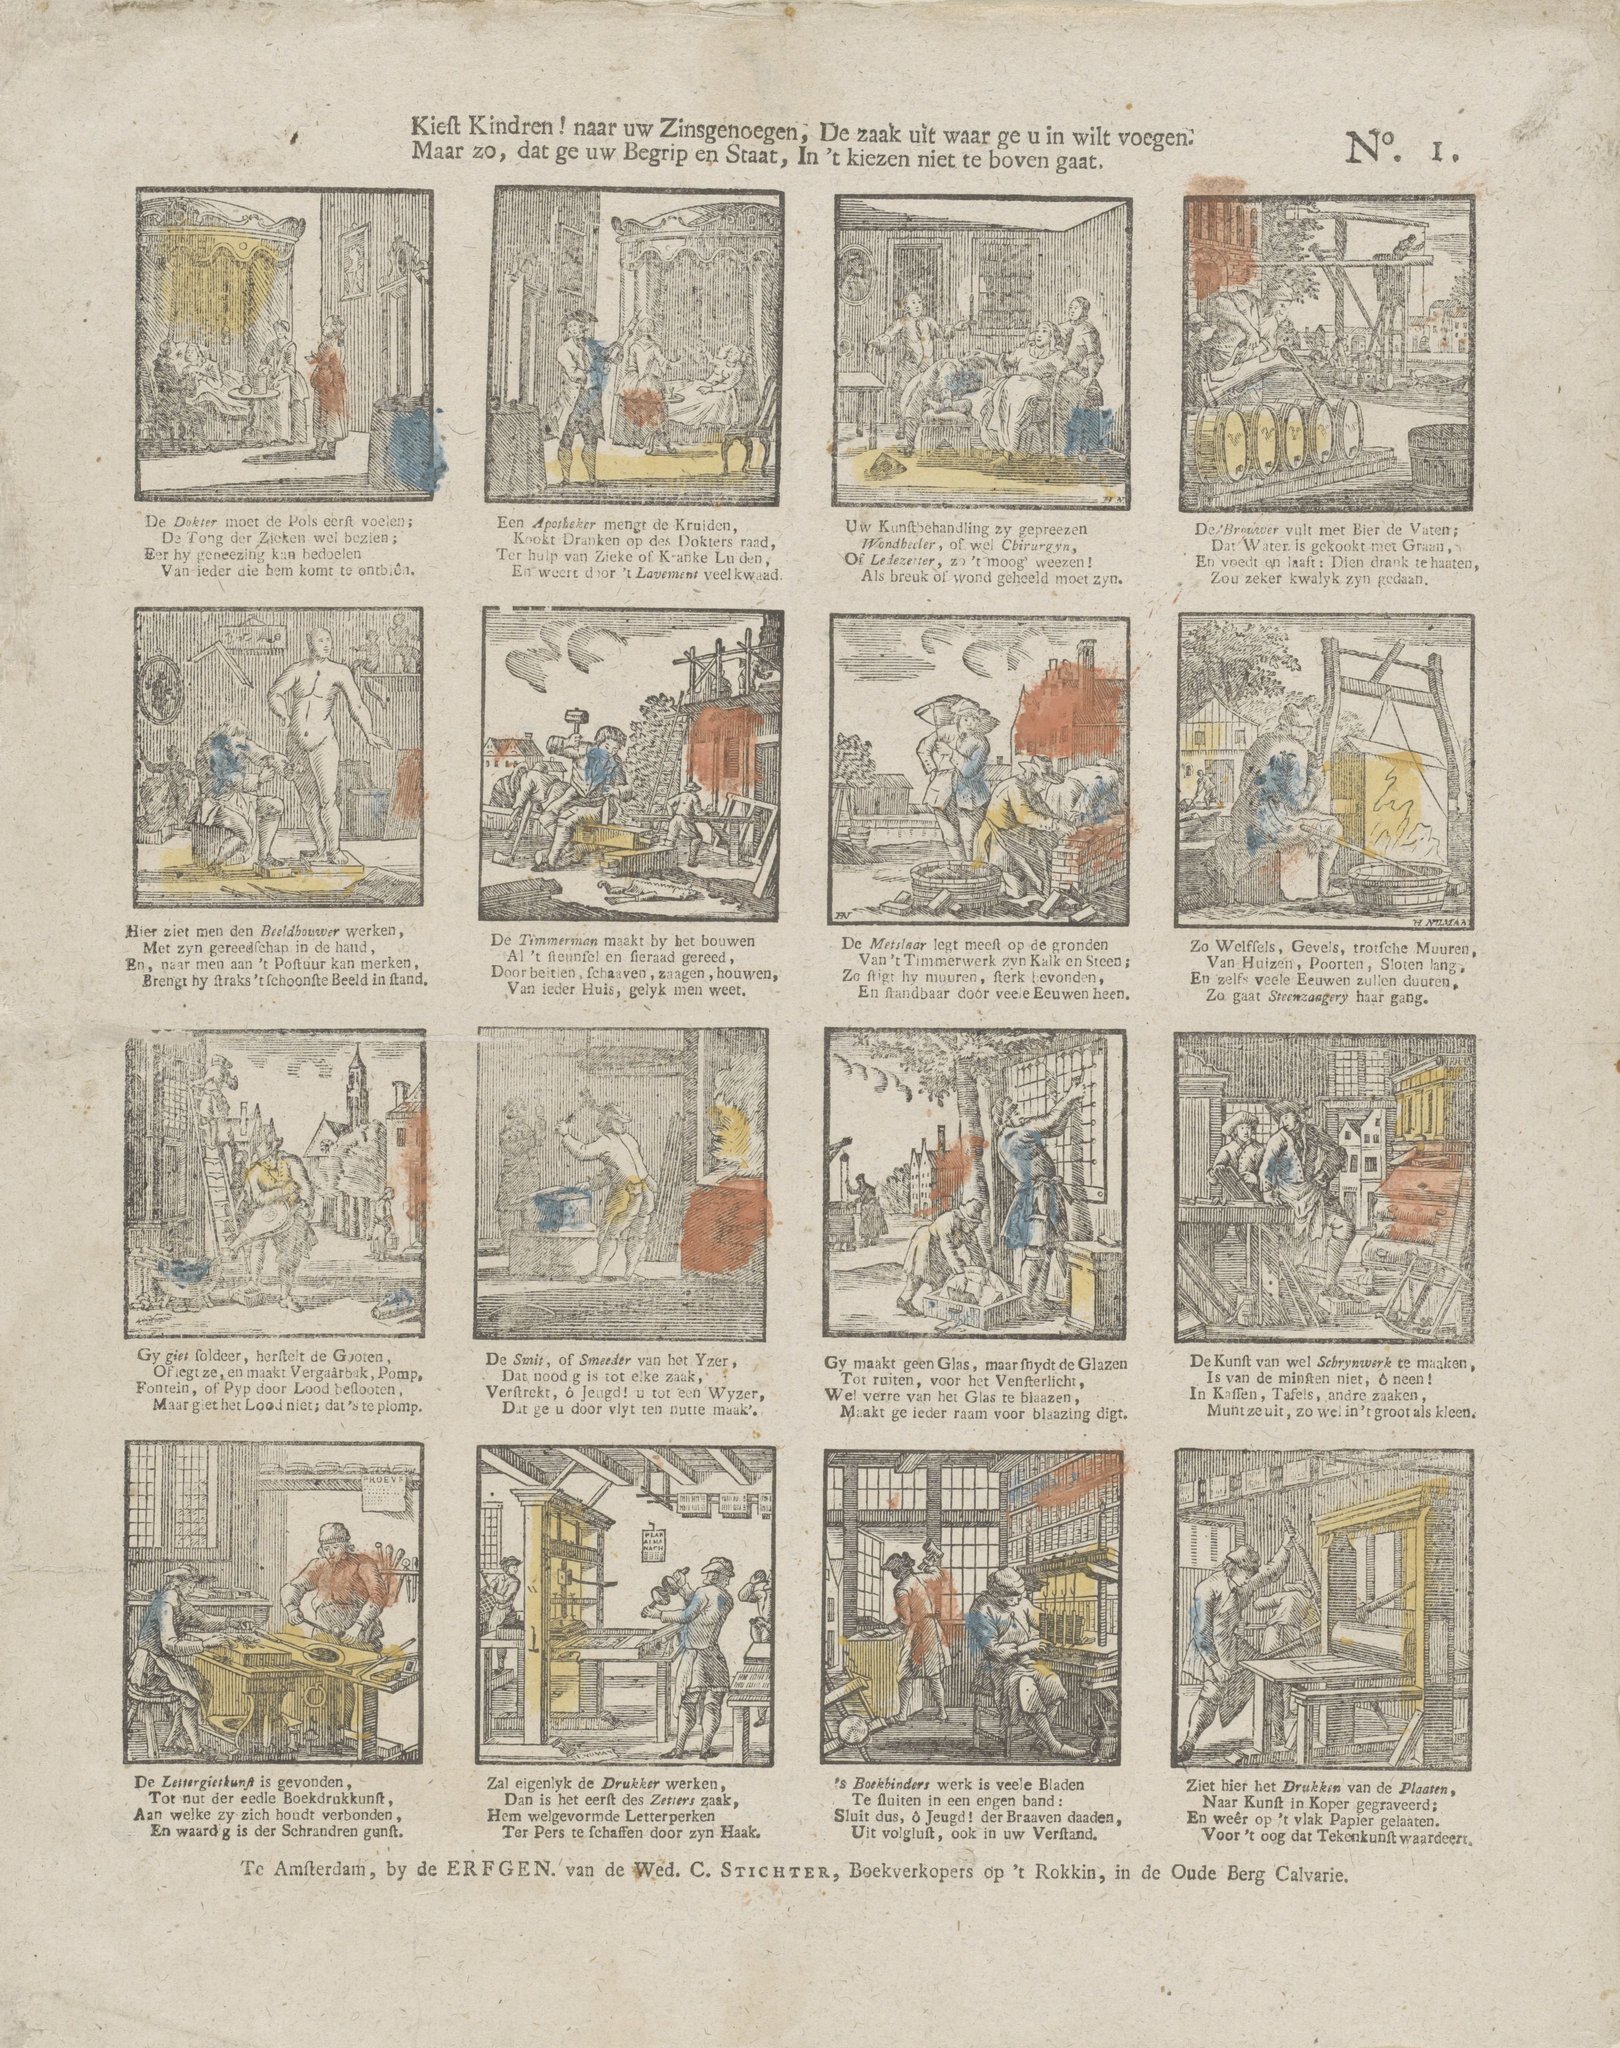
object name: popular print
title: Kiest kindren! naar uw zinsgenoegen, De zaak uit waar ge in wilt voegen. / Maar zo, dat ge uw begrip en staat, In 't kiezen niet te boven gaat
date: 1715-1813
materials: paper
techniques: colour, letterpress printing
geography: amsterdam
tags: carpenter, craft-production, skilled handiwork, pharmacist, druggist, apothecary; pharmacy, drugstore, dispensing chemist, sculptor at work, physician, doctor, printer, crafts and industries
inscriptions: collector's mark: Lugt 2760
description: Blad met 16 voorstellingen van ambachtslieden en beroepen, zoals een dokter, een apotheker en een timmerman. Onder elke voorstelling een vierregelig vers. Genummerd rechtsboven: No. 1.